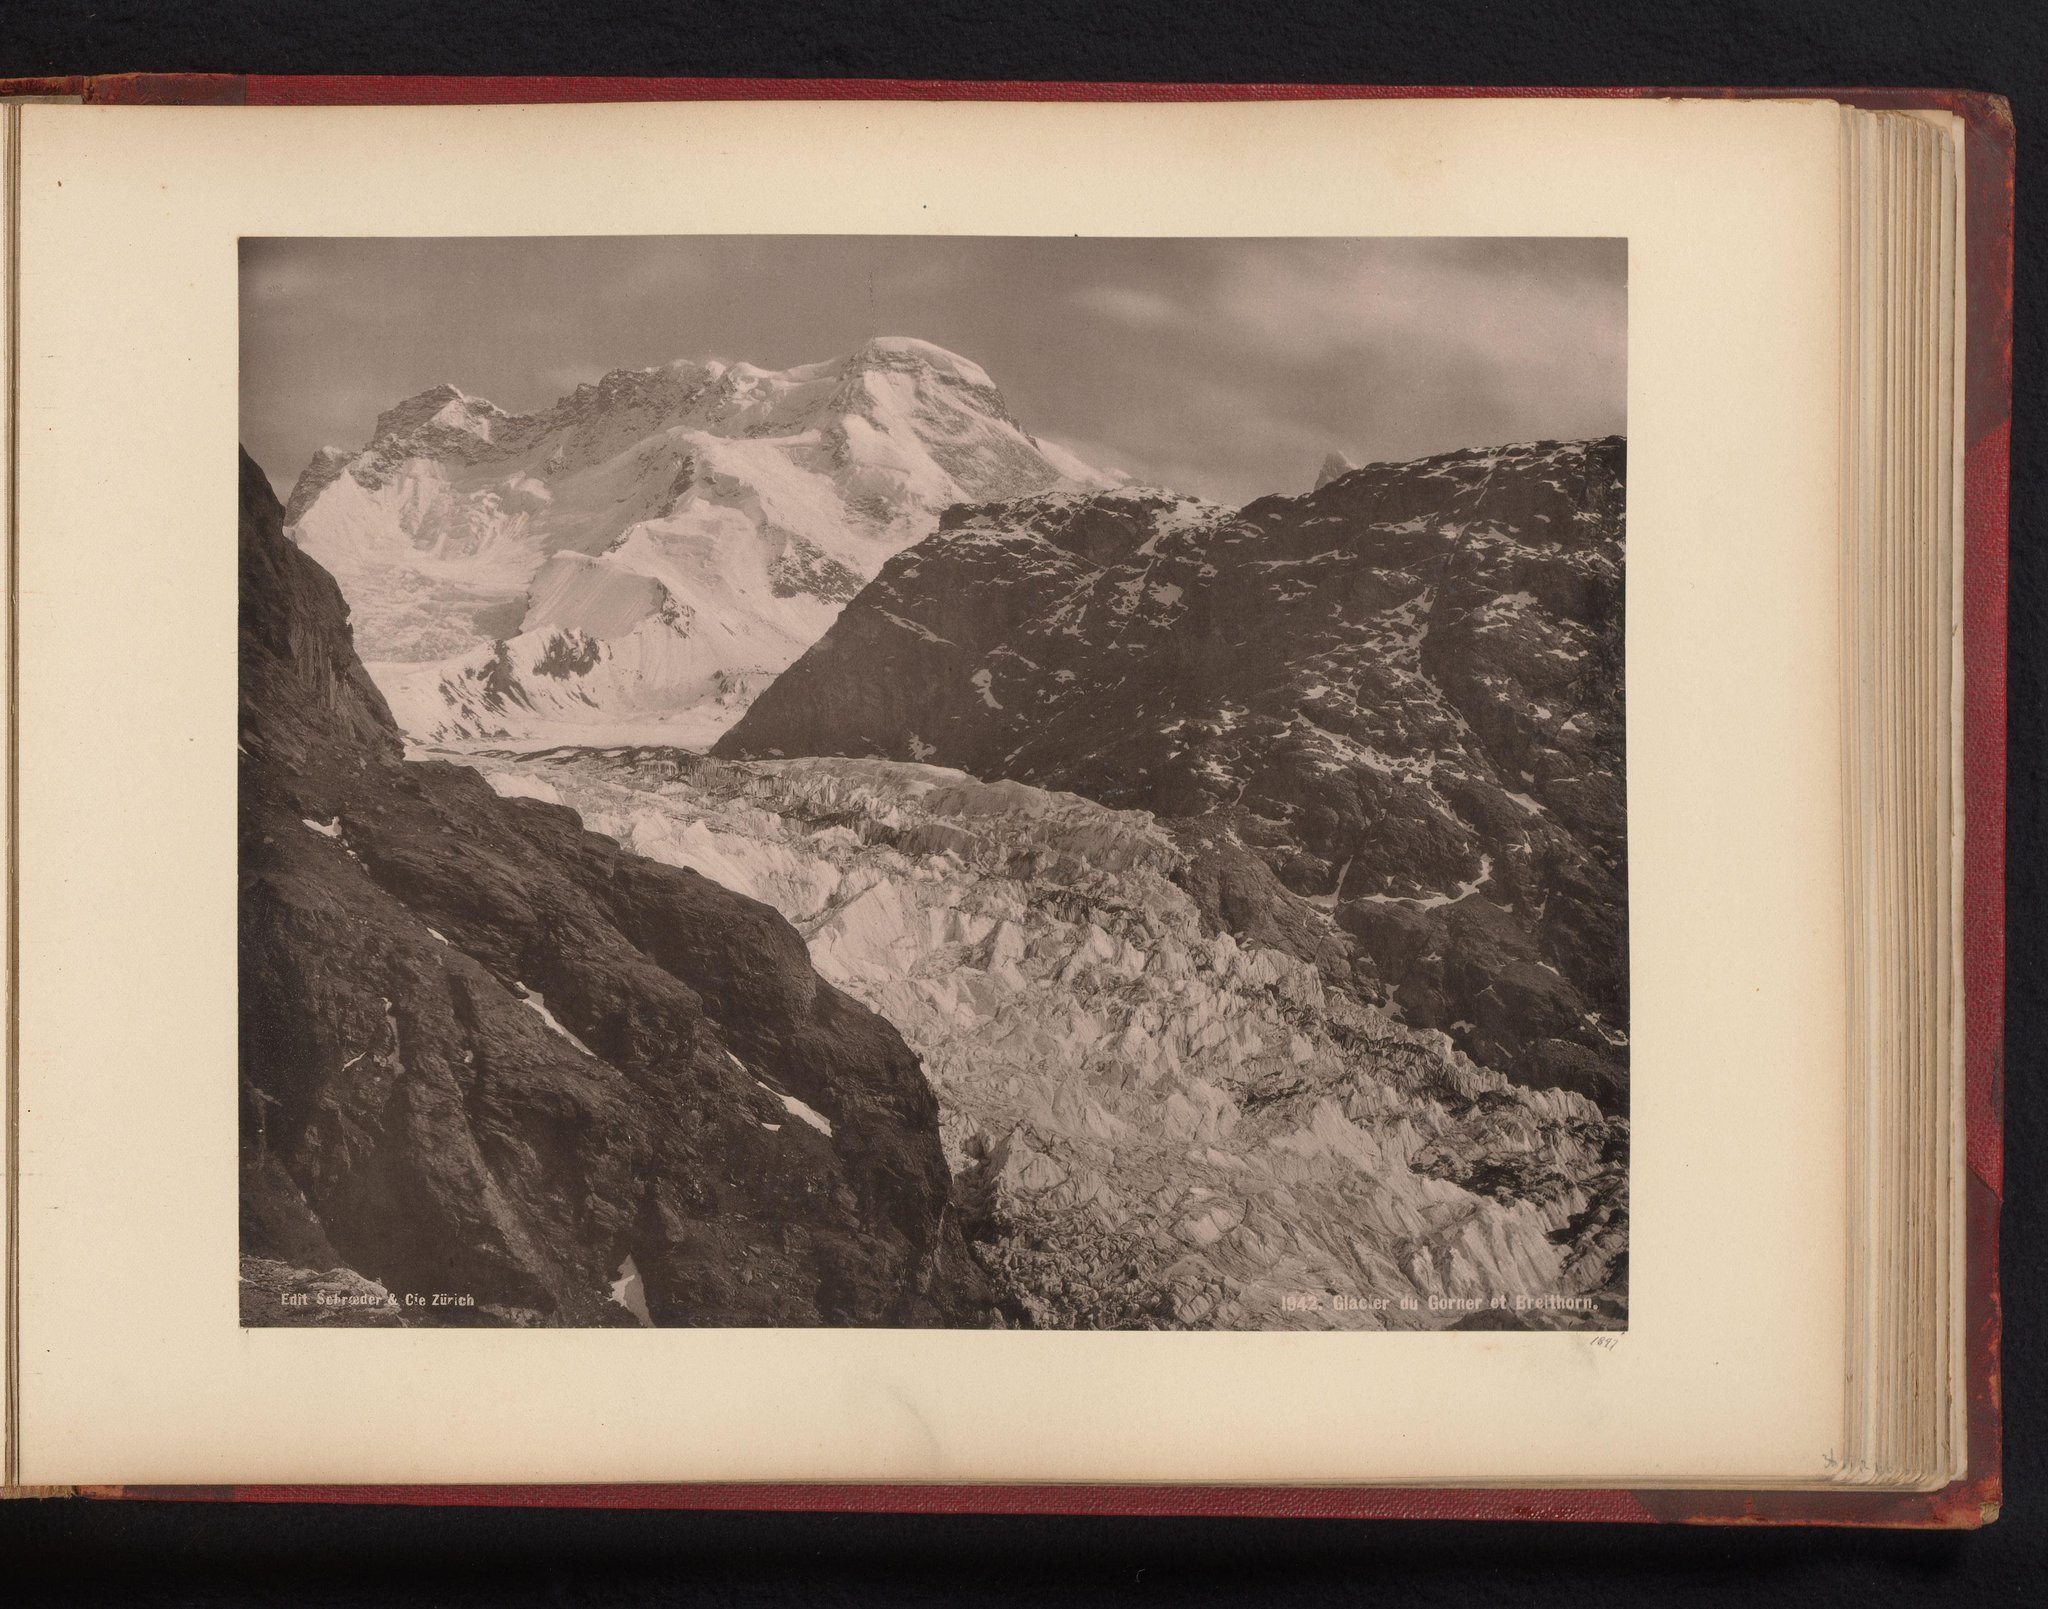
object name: album leaf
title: Gezicht op de Gornergletsjer met de Breithorn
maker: Anonymous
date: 1897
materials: paper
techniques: photograph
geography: zurich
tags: glacier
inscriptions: inscription: ‘Edit Schroeder & Cie. Zürich/ 1942. Glacier du Gorner et Breithorn.’, annotation: ‘1897’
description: Deze prent maakt deel uit van een album.